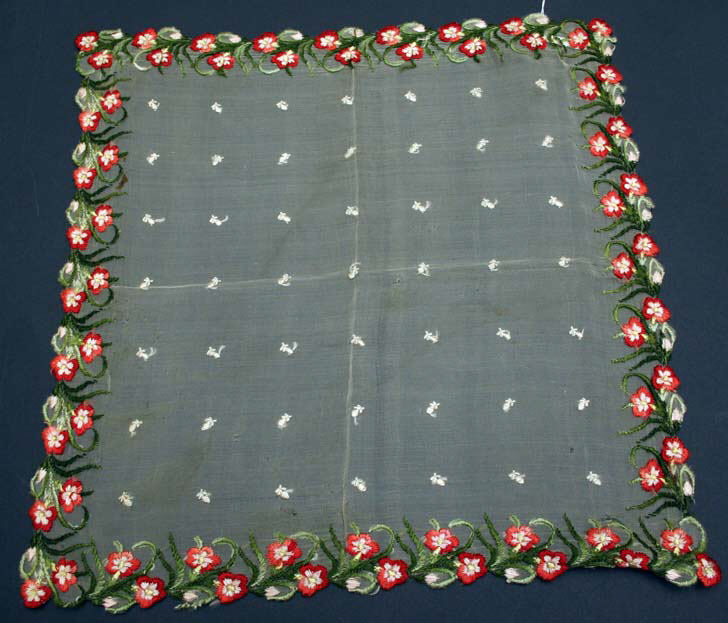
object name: handkerchief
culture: french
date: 1885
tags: flowers